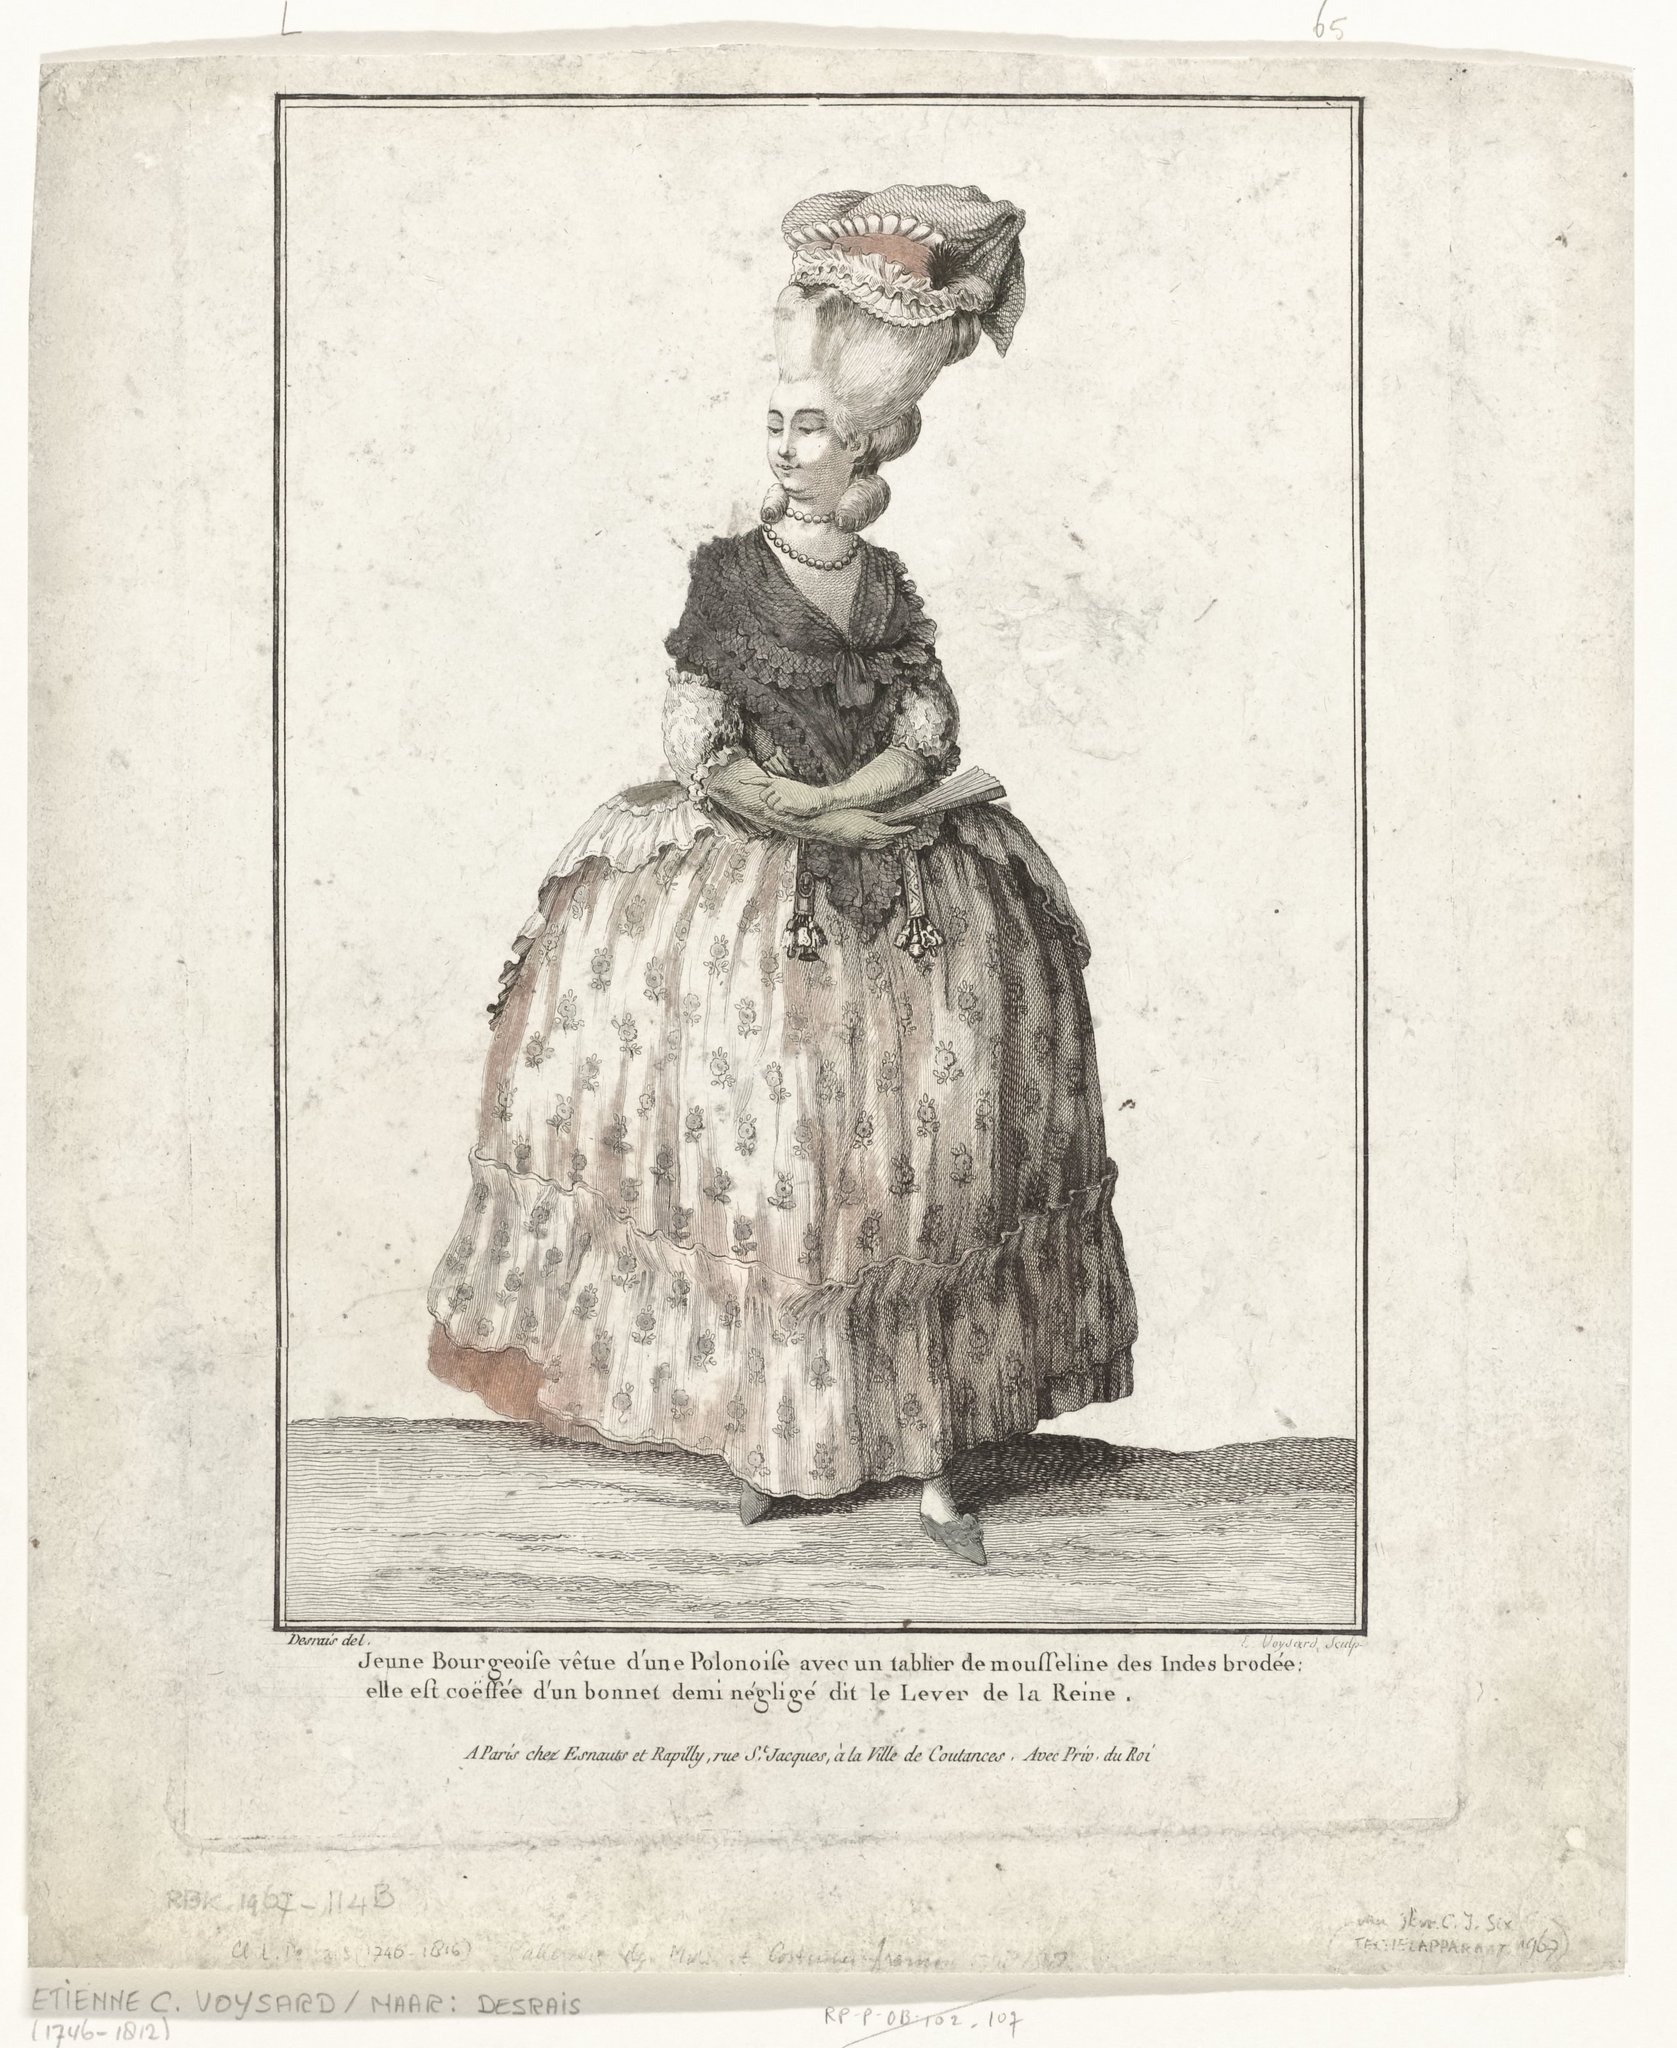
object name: fashion print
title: Gallerie des Modes et Costumes Français, 1778, L.65: jeune Bourgeoise vêtue d'une Polonoise...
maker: etienne claude voysard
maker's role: print maker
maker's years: 1746-1812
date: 1778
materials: cardboard, ink, paper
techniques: colour, engraving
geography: france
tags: styles of hairdress - aa - ~ women, fashion plates, clothes, costume (+ women's clothes), fan, dress, gown: robe à la polonaise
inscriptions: address: ‘A Paris, chez Esnauts et Rapilly, rue St. Jacques, a la Ville de Coutances.’, caption: ‘Jeune Bourgeoise vetue d'une Polonoise avec un tablier de mousseline des Indes brodée: elle est coeffée d'un bonnet demi négligé dit Le Lever de la Reine.’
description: Burgervrouw in een 'robe à la Polonaise' waarover een 'tablier' van mousseline. Op het hoge kapsel 'demi négligé' een bonnet die 'Le Lever de la Reine' werd genoemd. Prent uit de serie L, 11e Cahier des Costumes Français, 5e Suite d'Habillemens à la mode en 1778. Gallerie des Modes et Costumes français.